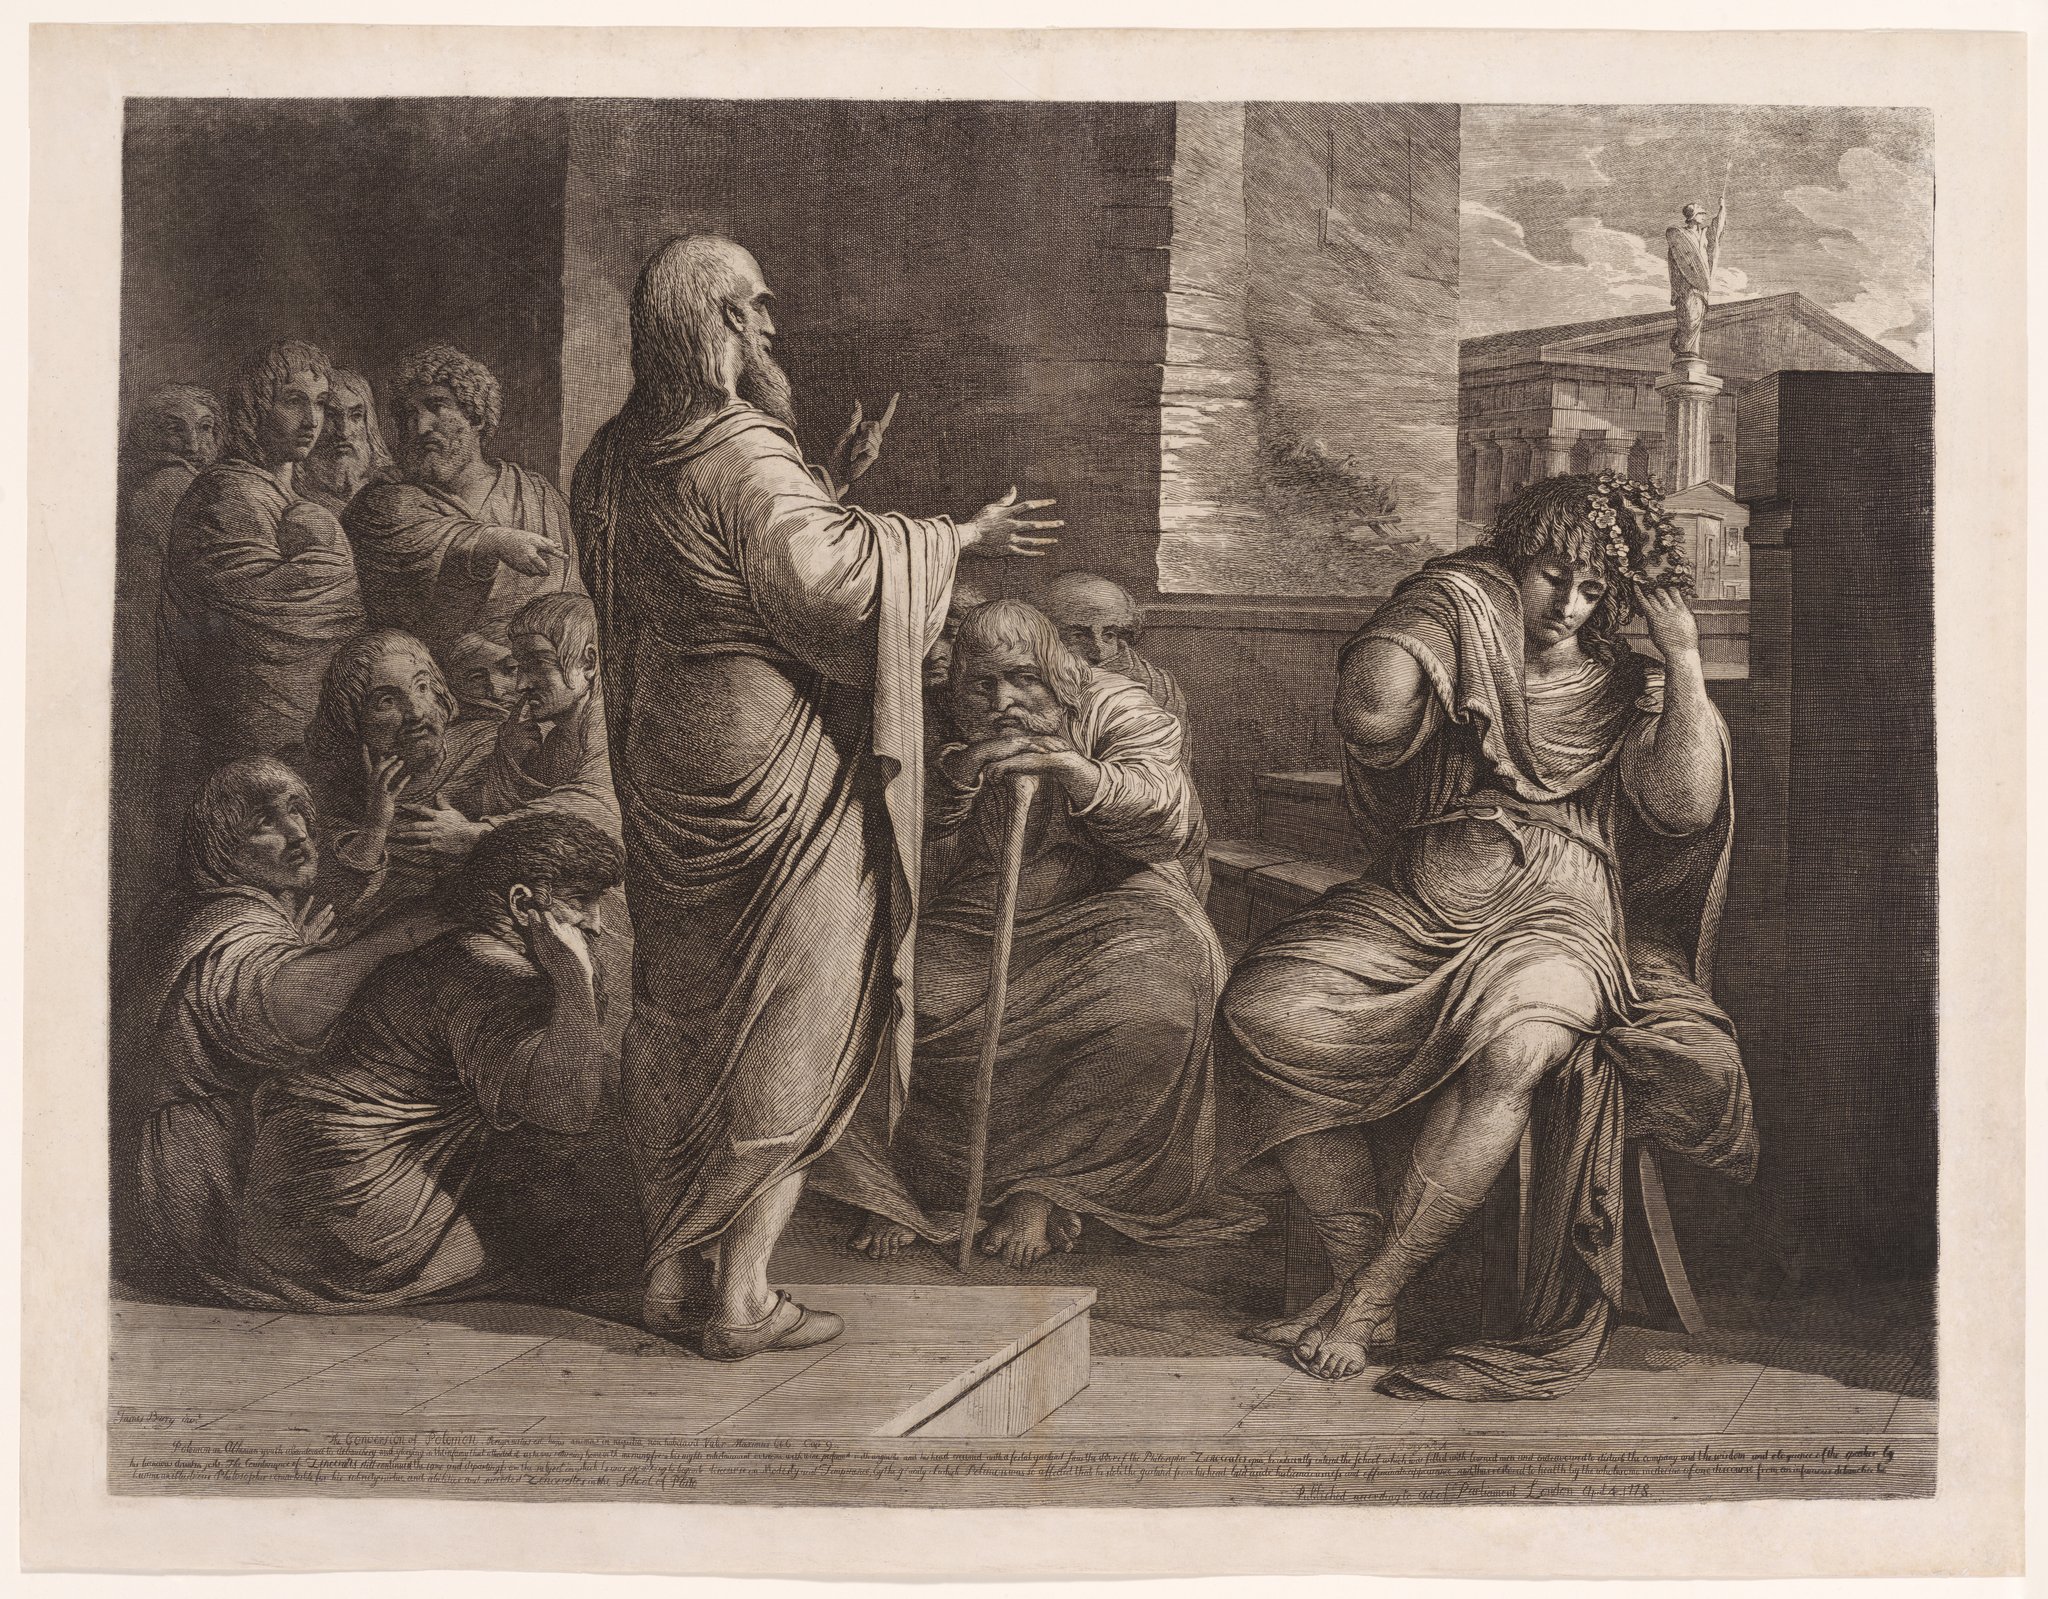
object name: print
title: The Conversion of Polemon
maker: james barry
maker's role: artist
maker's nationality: irish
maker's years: 1741-1806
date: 1778-1790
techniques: aquatint, engraving, etching, roulette